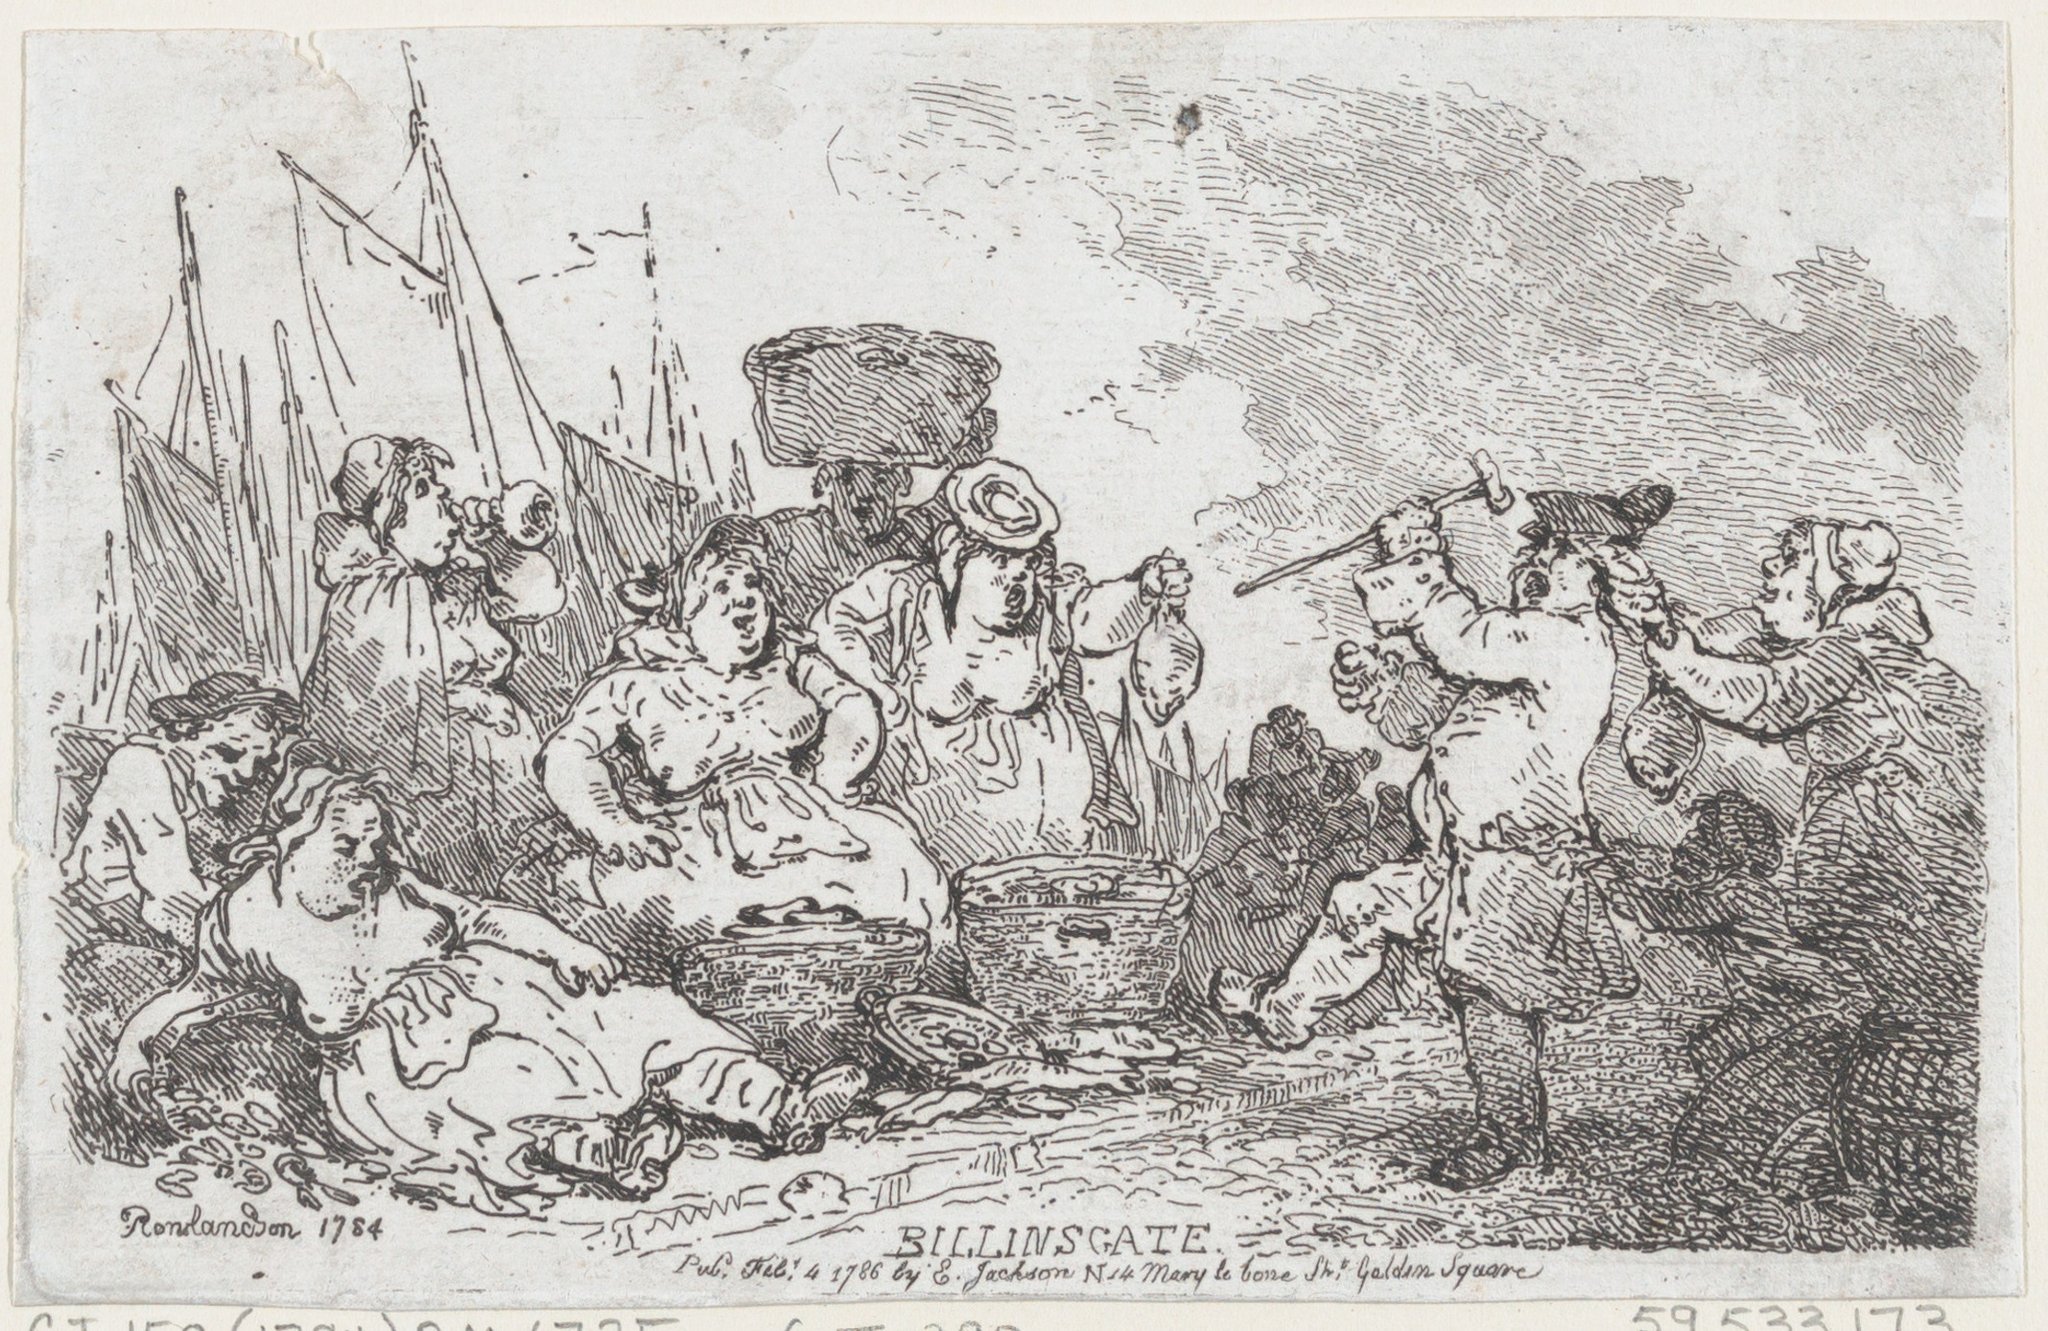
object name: print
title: Billingsgate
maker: thomas rowlandson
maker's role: artist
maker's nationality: british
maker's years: 1757-1827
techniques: etching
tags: satire,men,women,fish,drinking